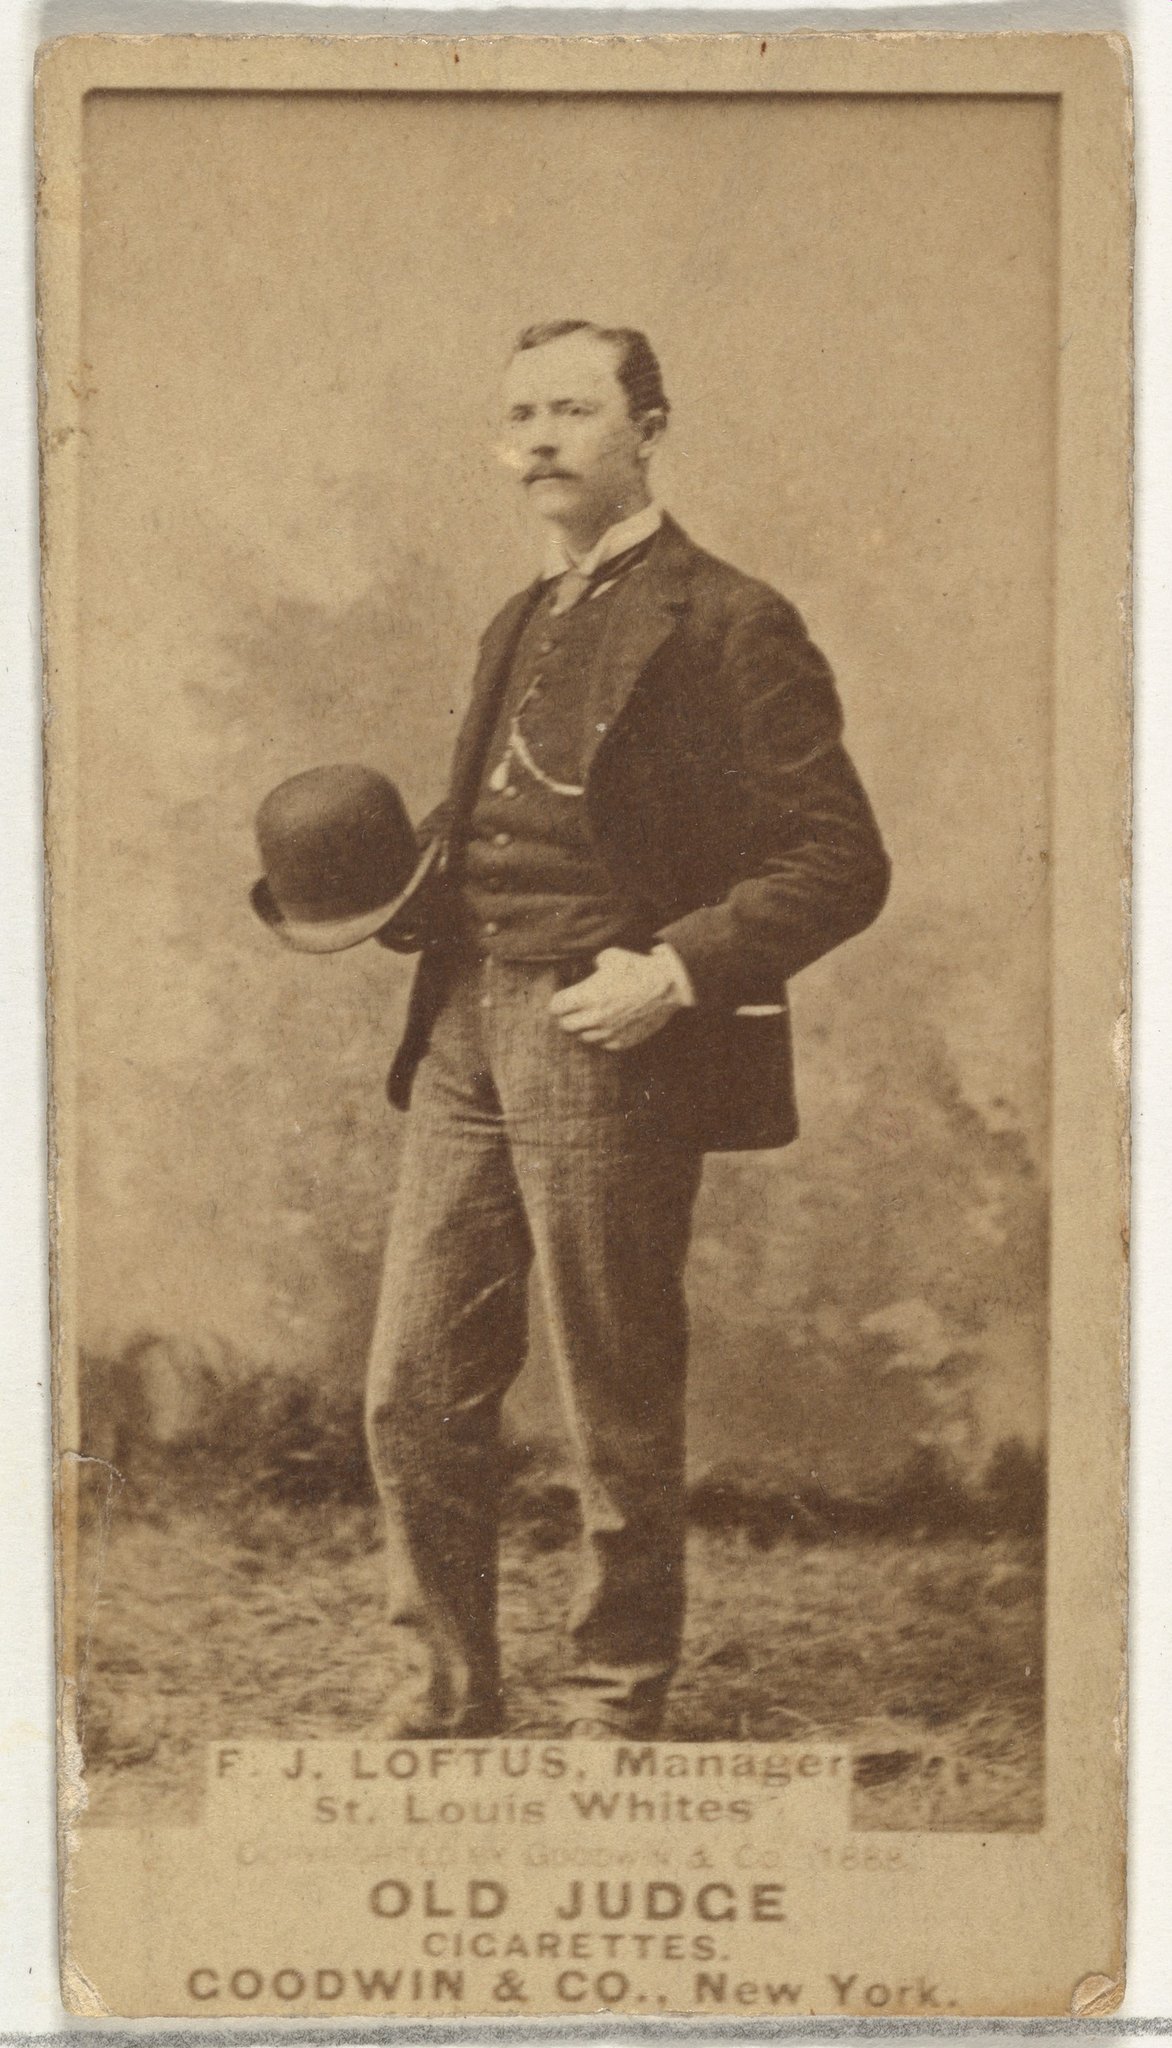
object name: baseball card, photograph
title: Loftus, Manager, St. Louis Whites, from the Old Judge series (N172) for Old Judge Cigarettes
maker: goodwin & company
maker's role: publisher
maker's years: 1850-1950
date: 1888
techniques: albumen silver print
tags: men,portraits,baseball,athletes